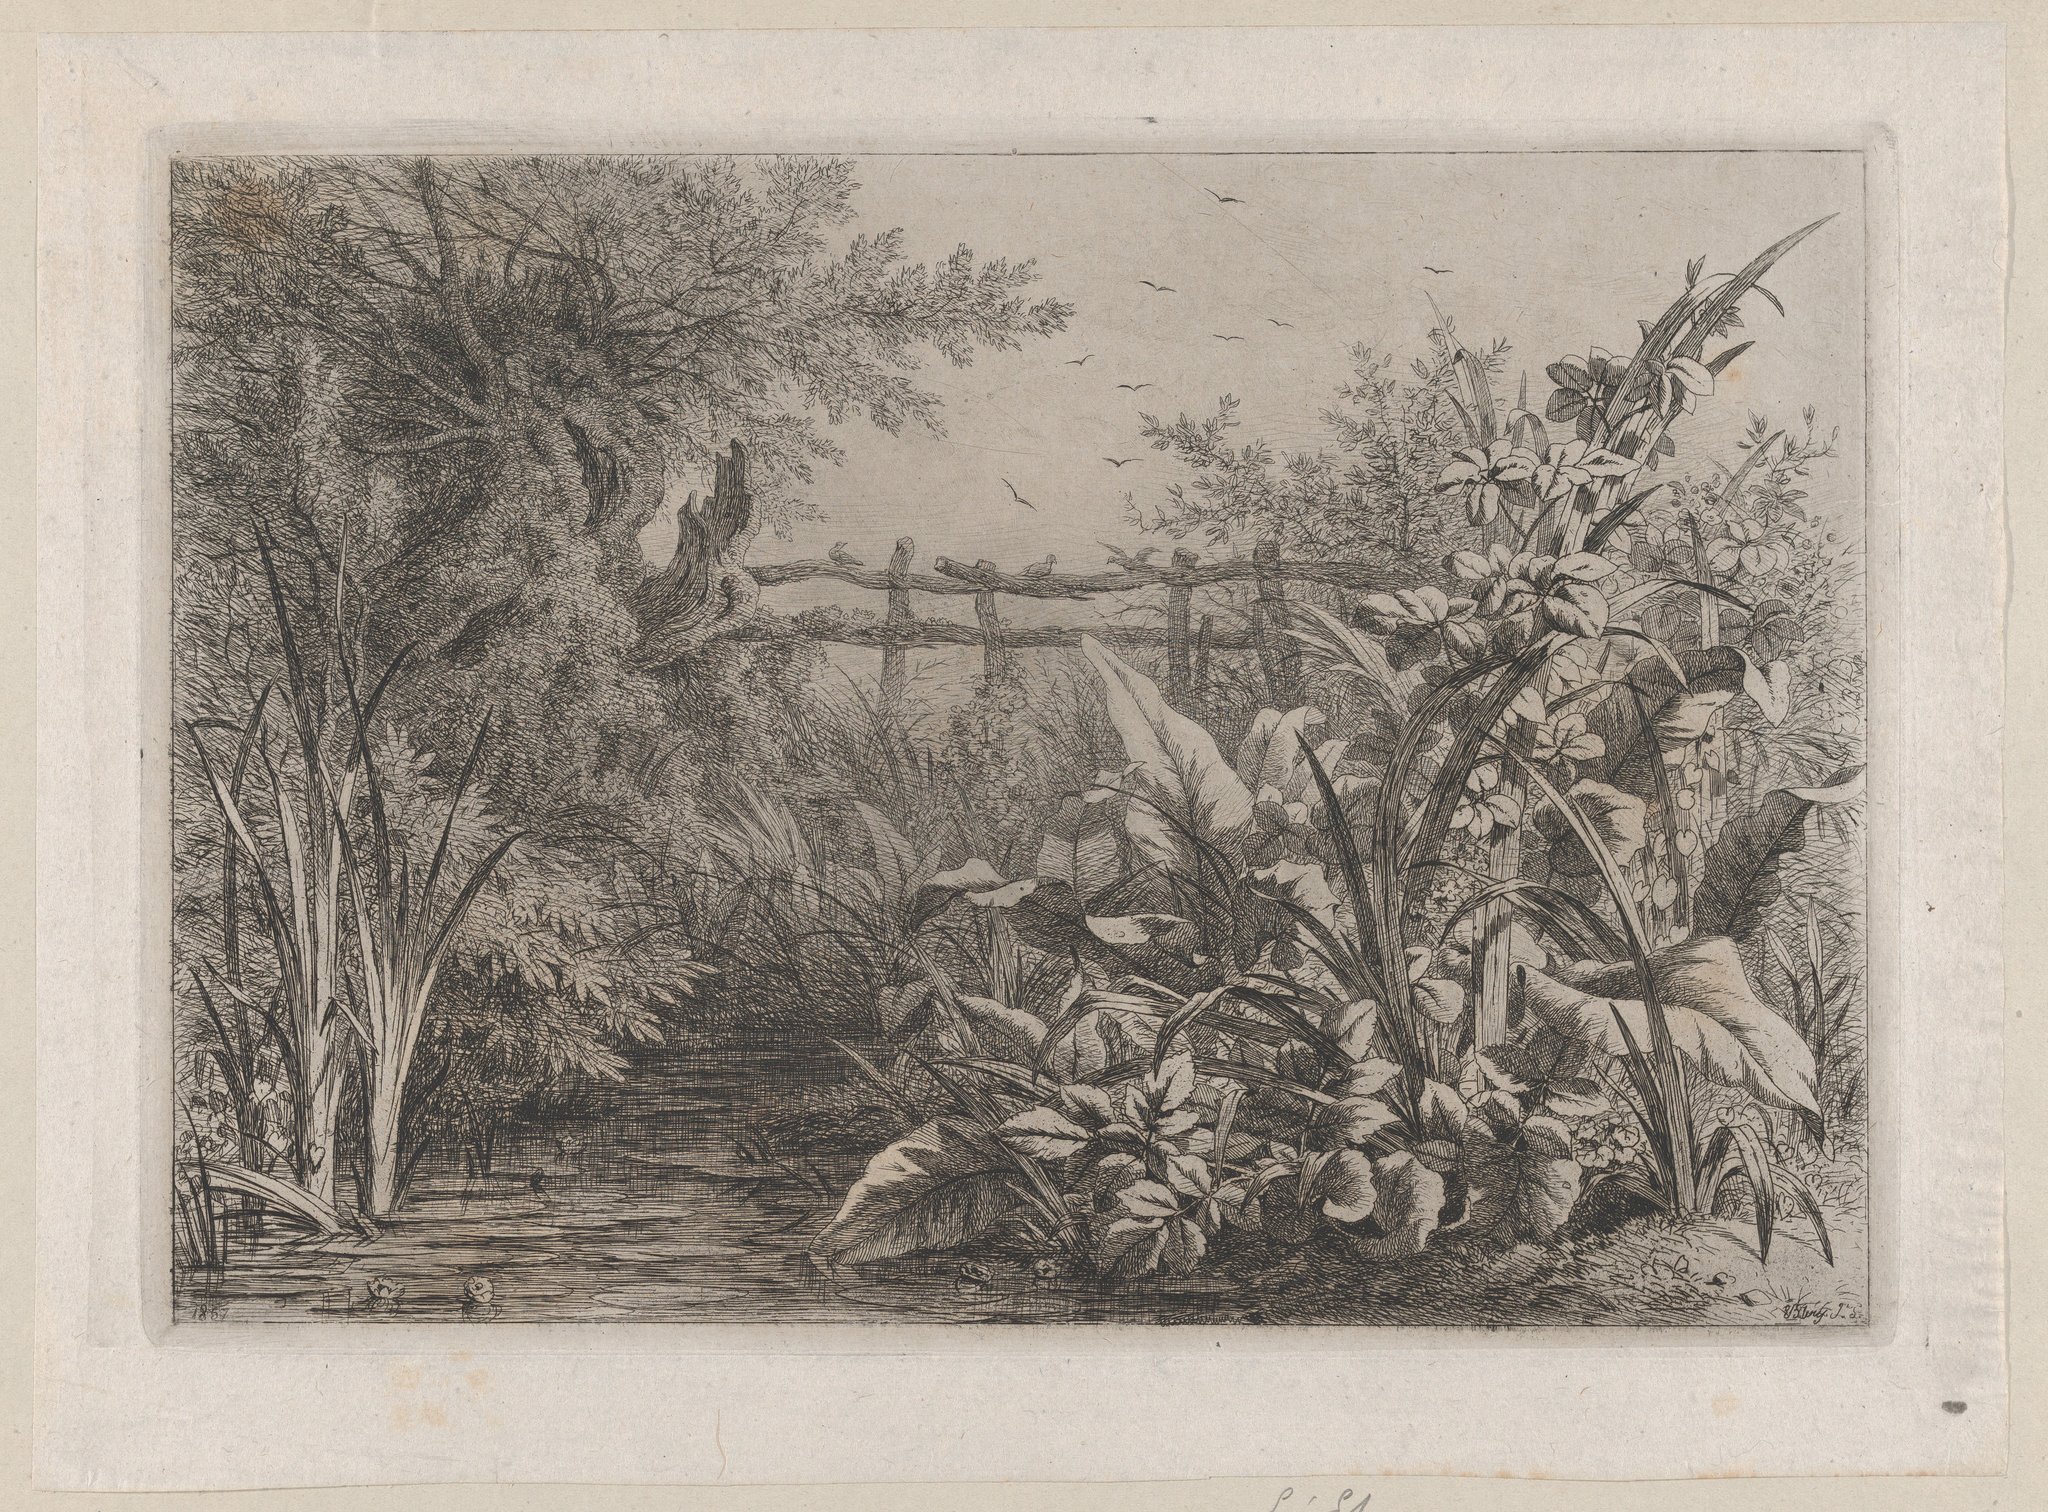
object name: print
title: The Pond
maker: eugène bléry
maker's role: artist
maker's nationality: french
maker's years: 1805-1887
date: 1857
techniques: etching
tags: ponds,flowers,plants